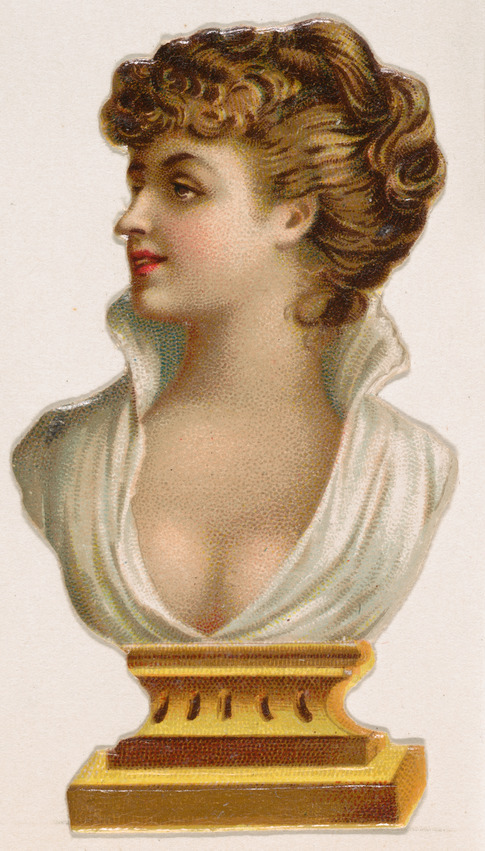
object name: print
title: Statue, from the Novelties series (N228, Type 4) issued by Kinney Bros.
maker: kinney brothers tobacco company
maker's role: publisher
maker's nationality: american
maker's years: 1869-2011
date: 1889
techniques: color lithograph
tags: profiles,women